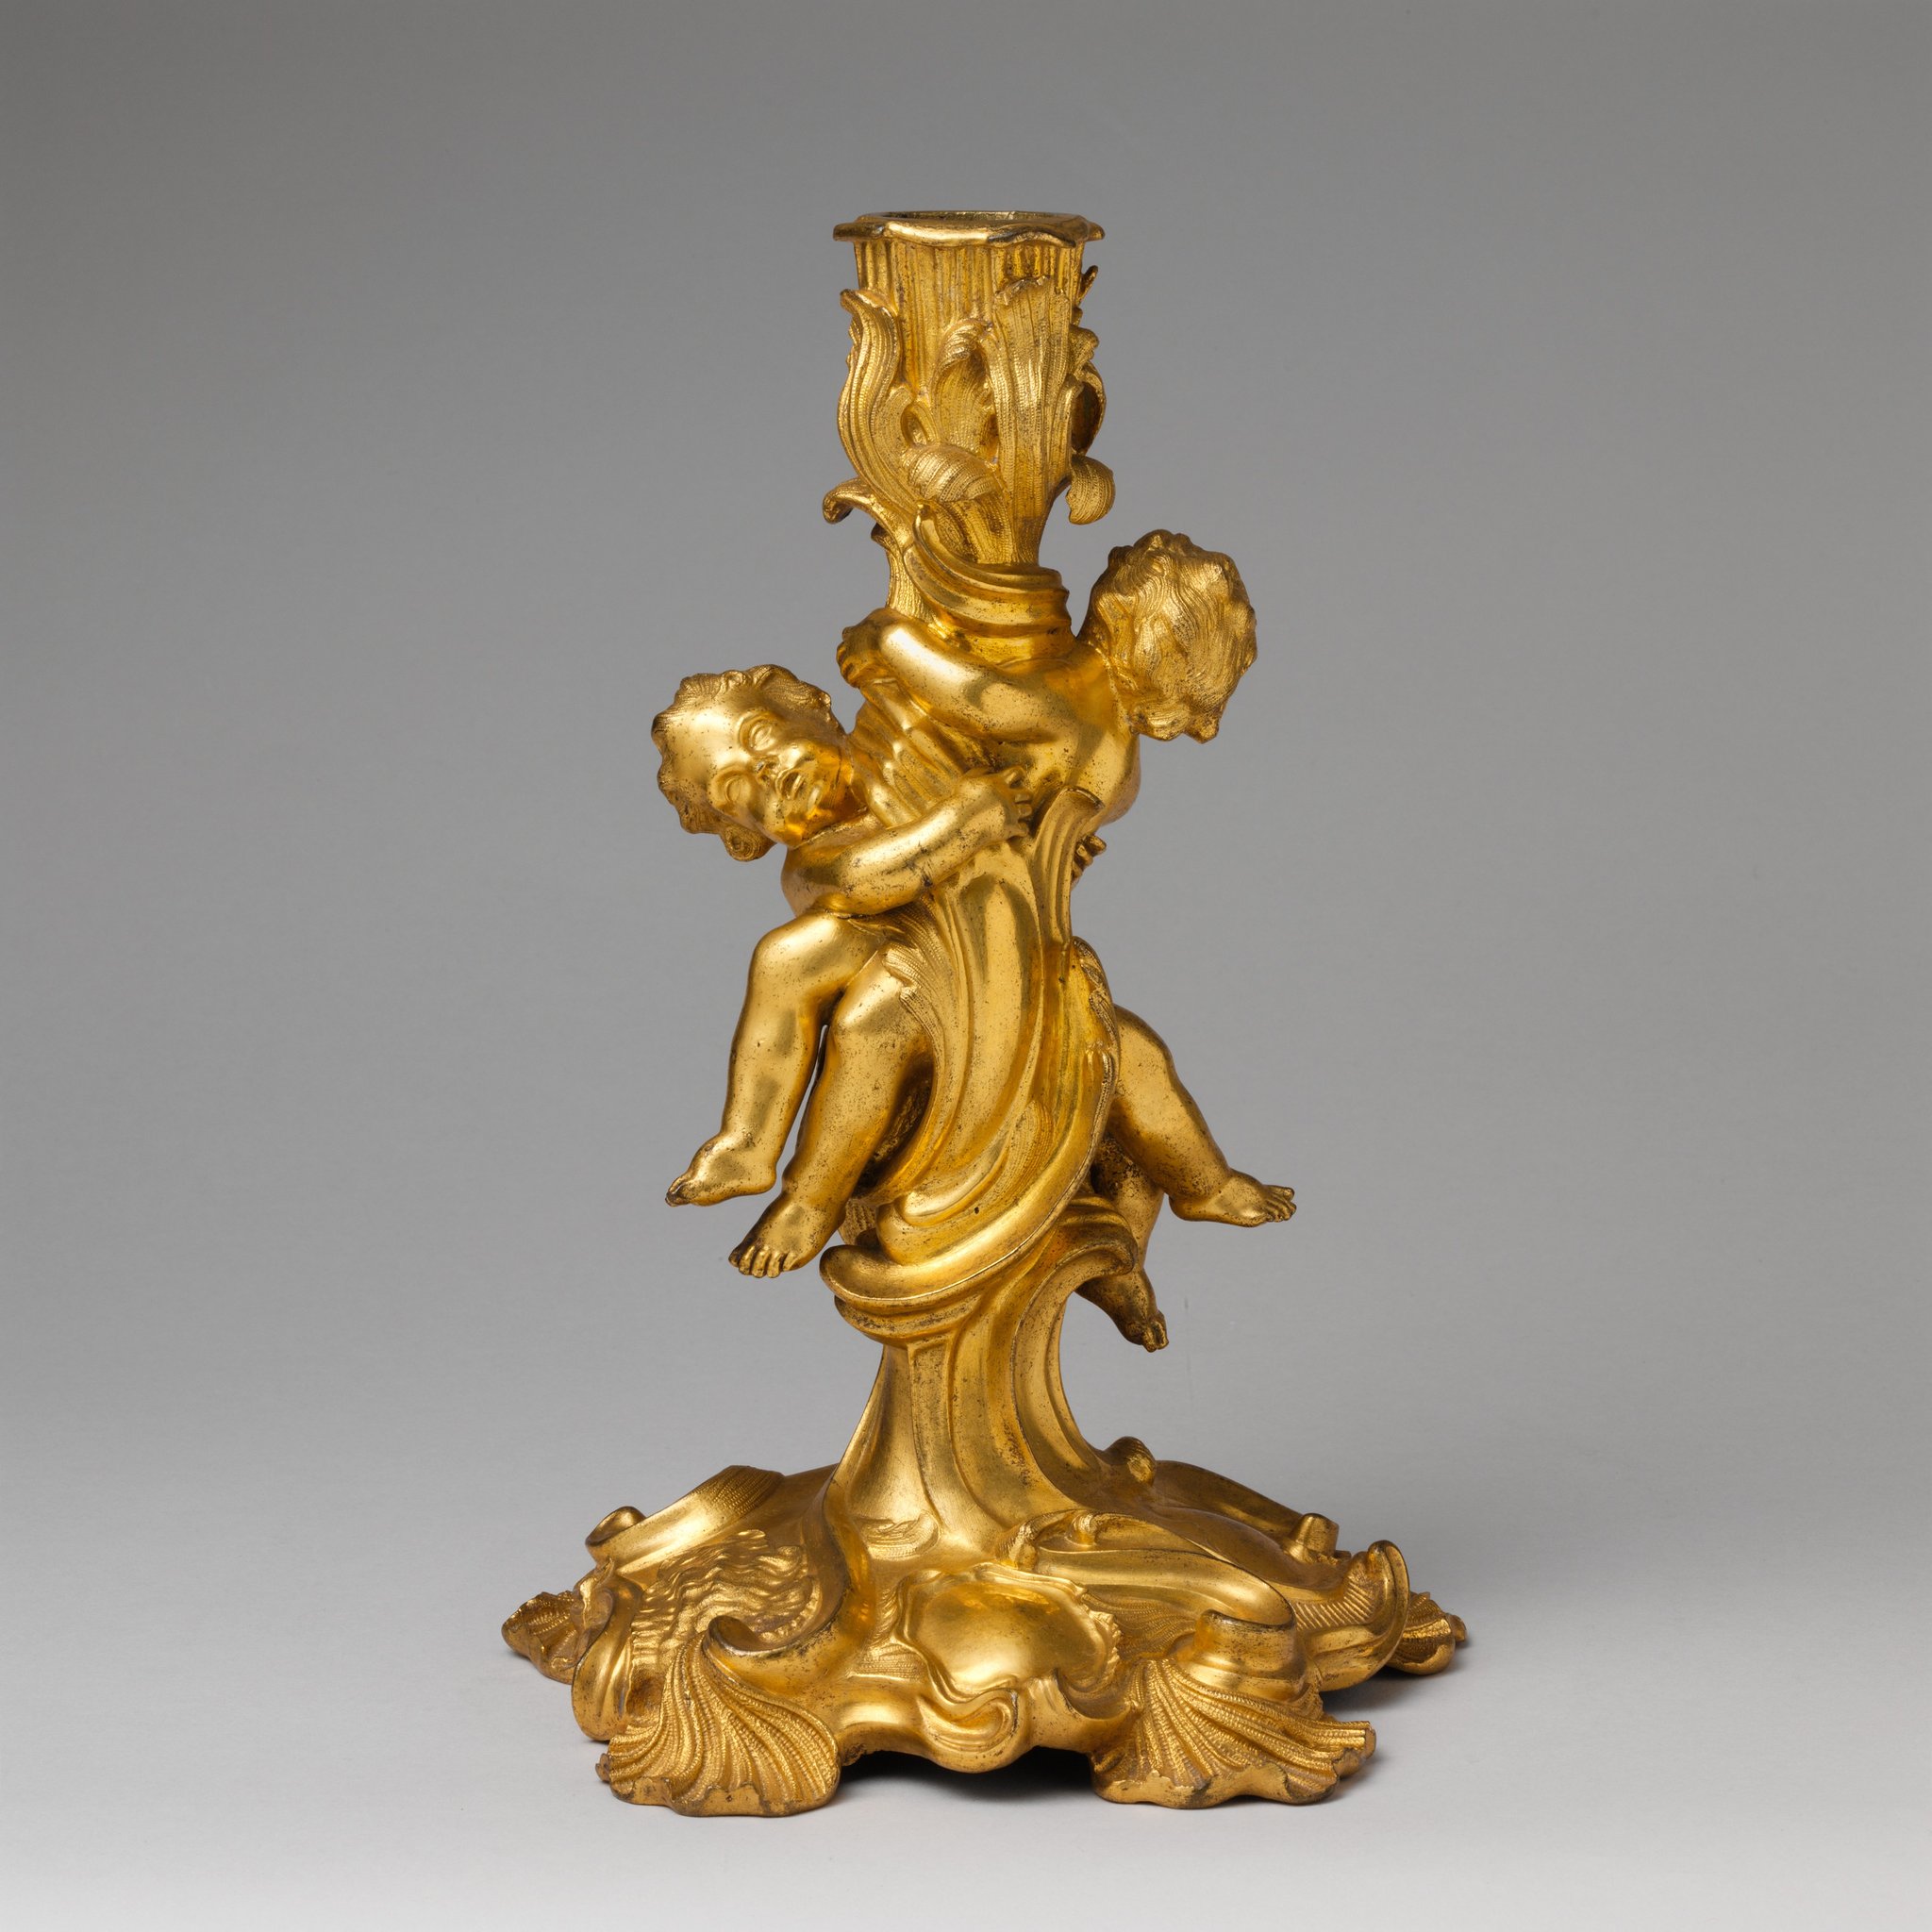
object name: candlestick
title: Pair of candlesticks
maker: juste aurèle meissonnier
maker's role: designer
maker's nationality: french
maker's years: 1695-1750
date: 1745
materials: gilt bronze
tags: putti